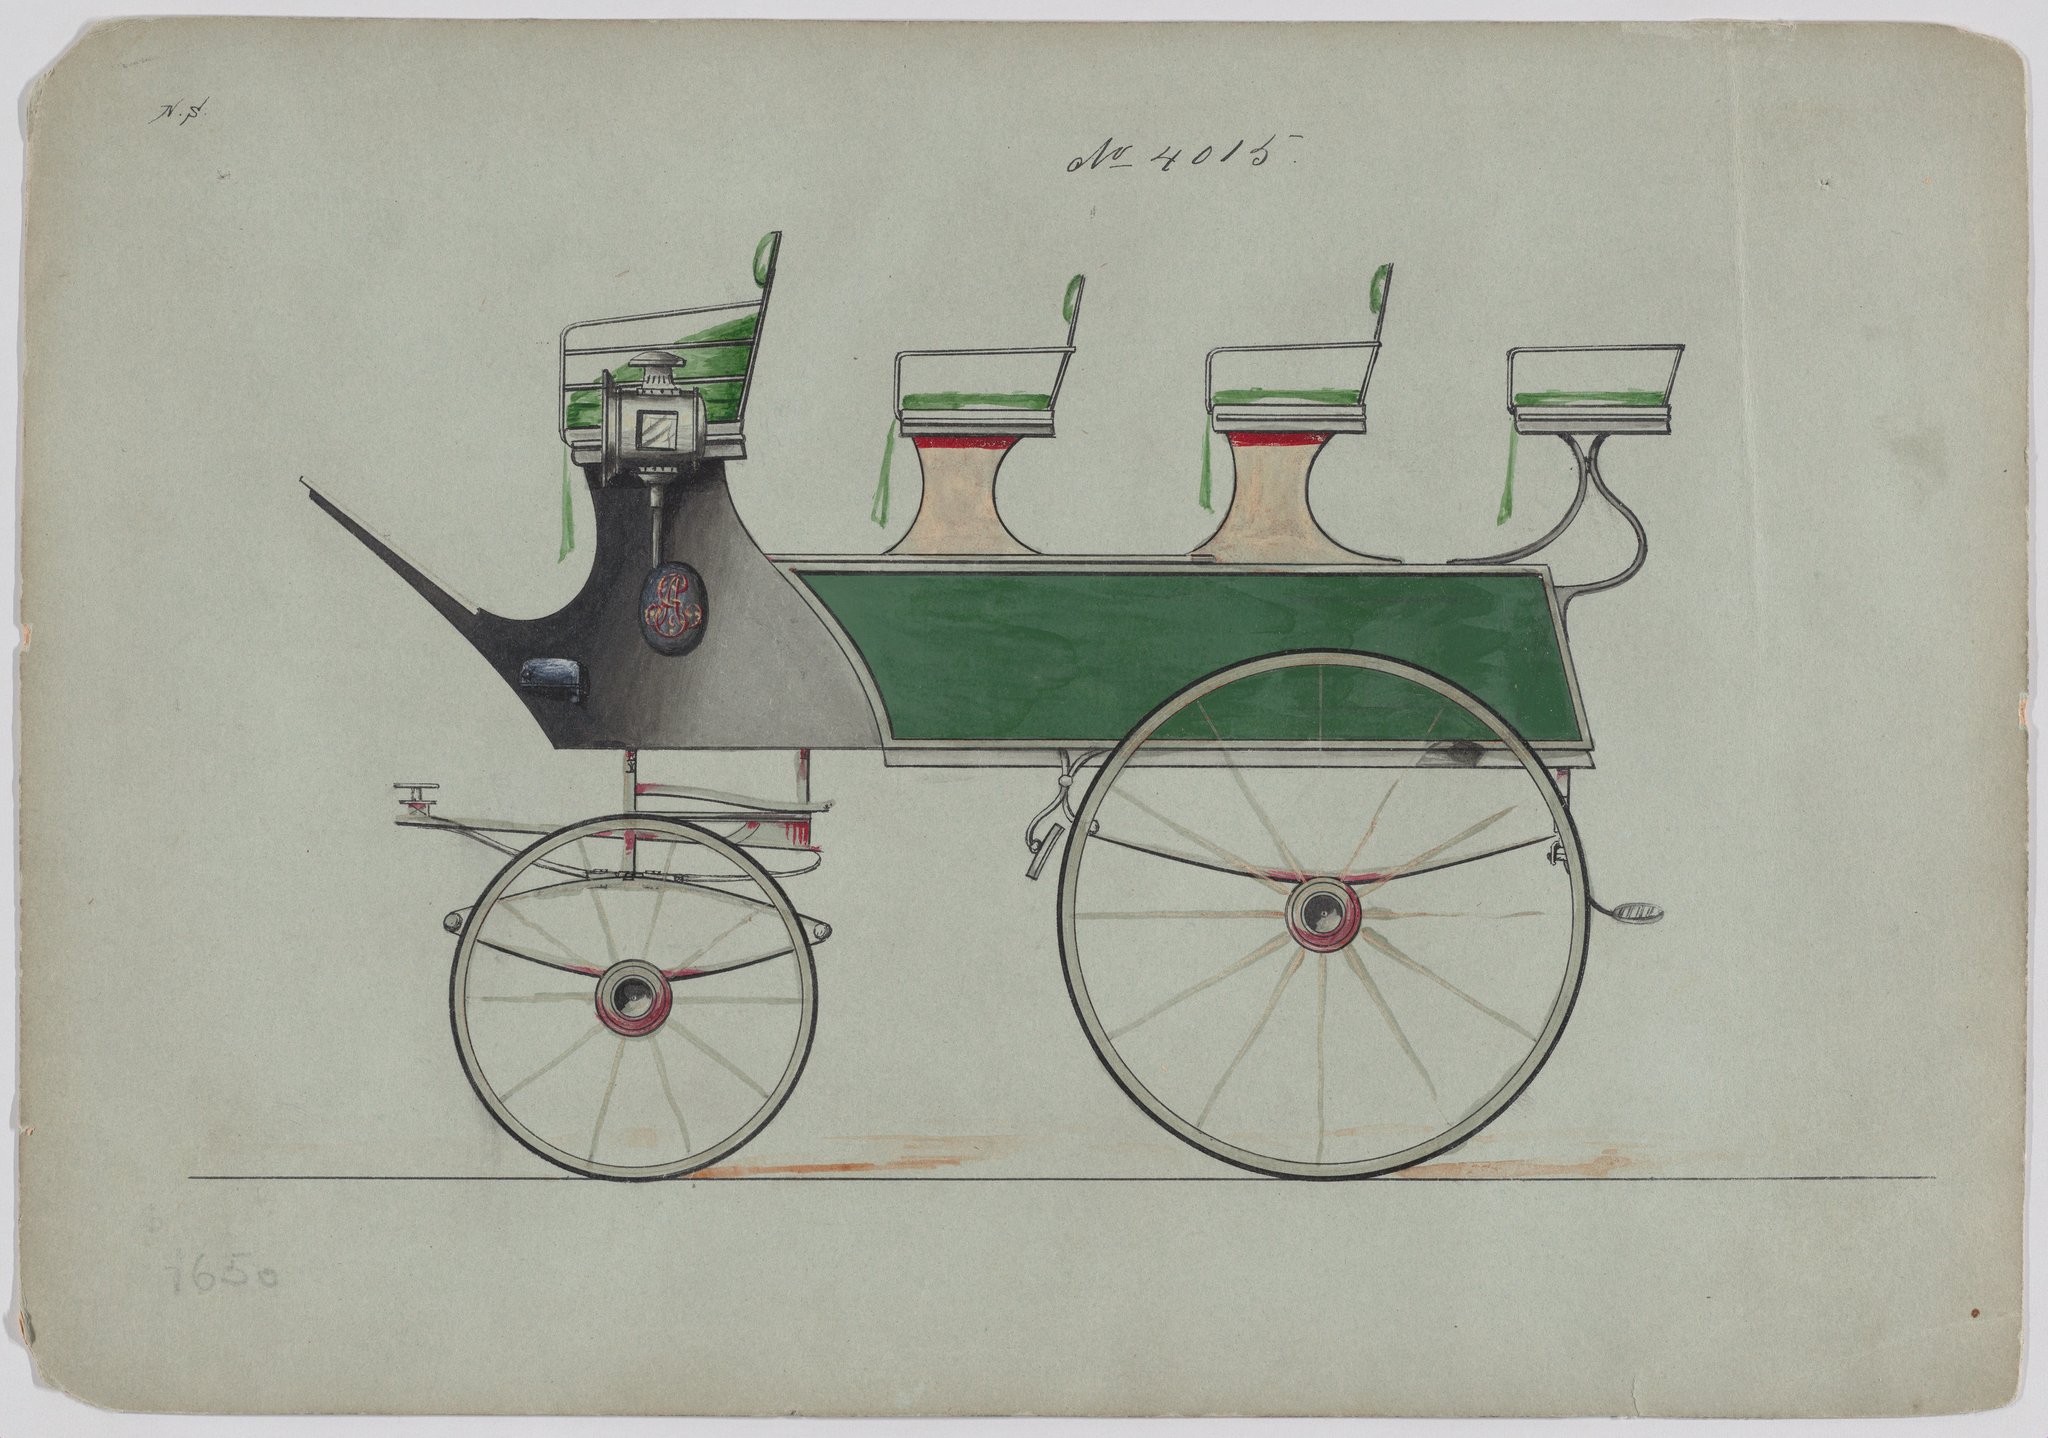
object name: drawing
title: Roof Seat Break #4015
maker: brewster & co.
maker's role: manufacturer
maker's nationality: american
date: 1888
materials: gouache, graphite, gum arabic, ink, watercolor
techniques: pen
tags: carriages